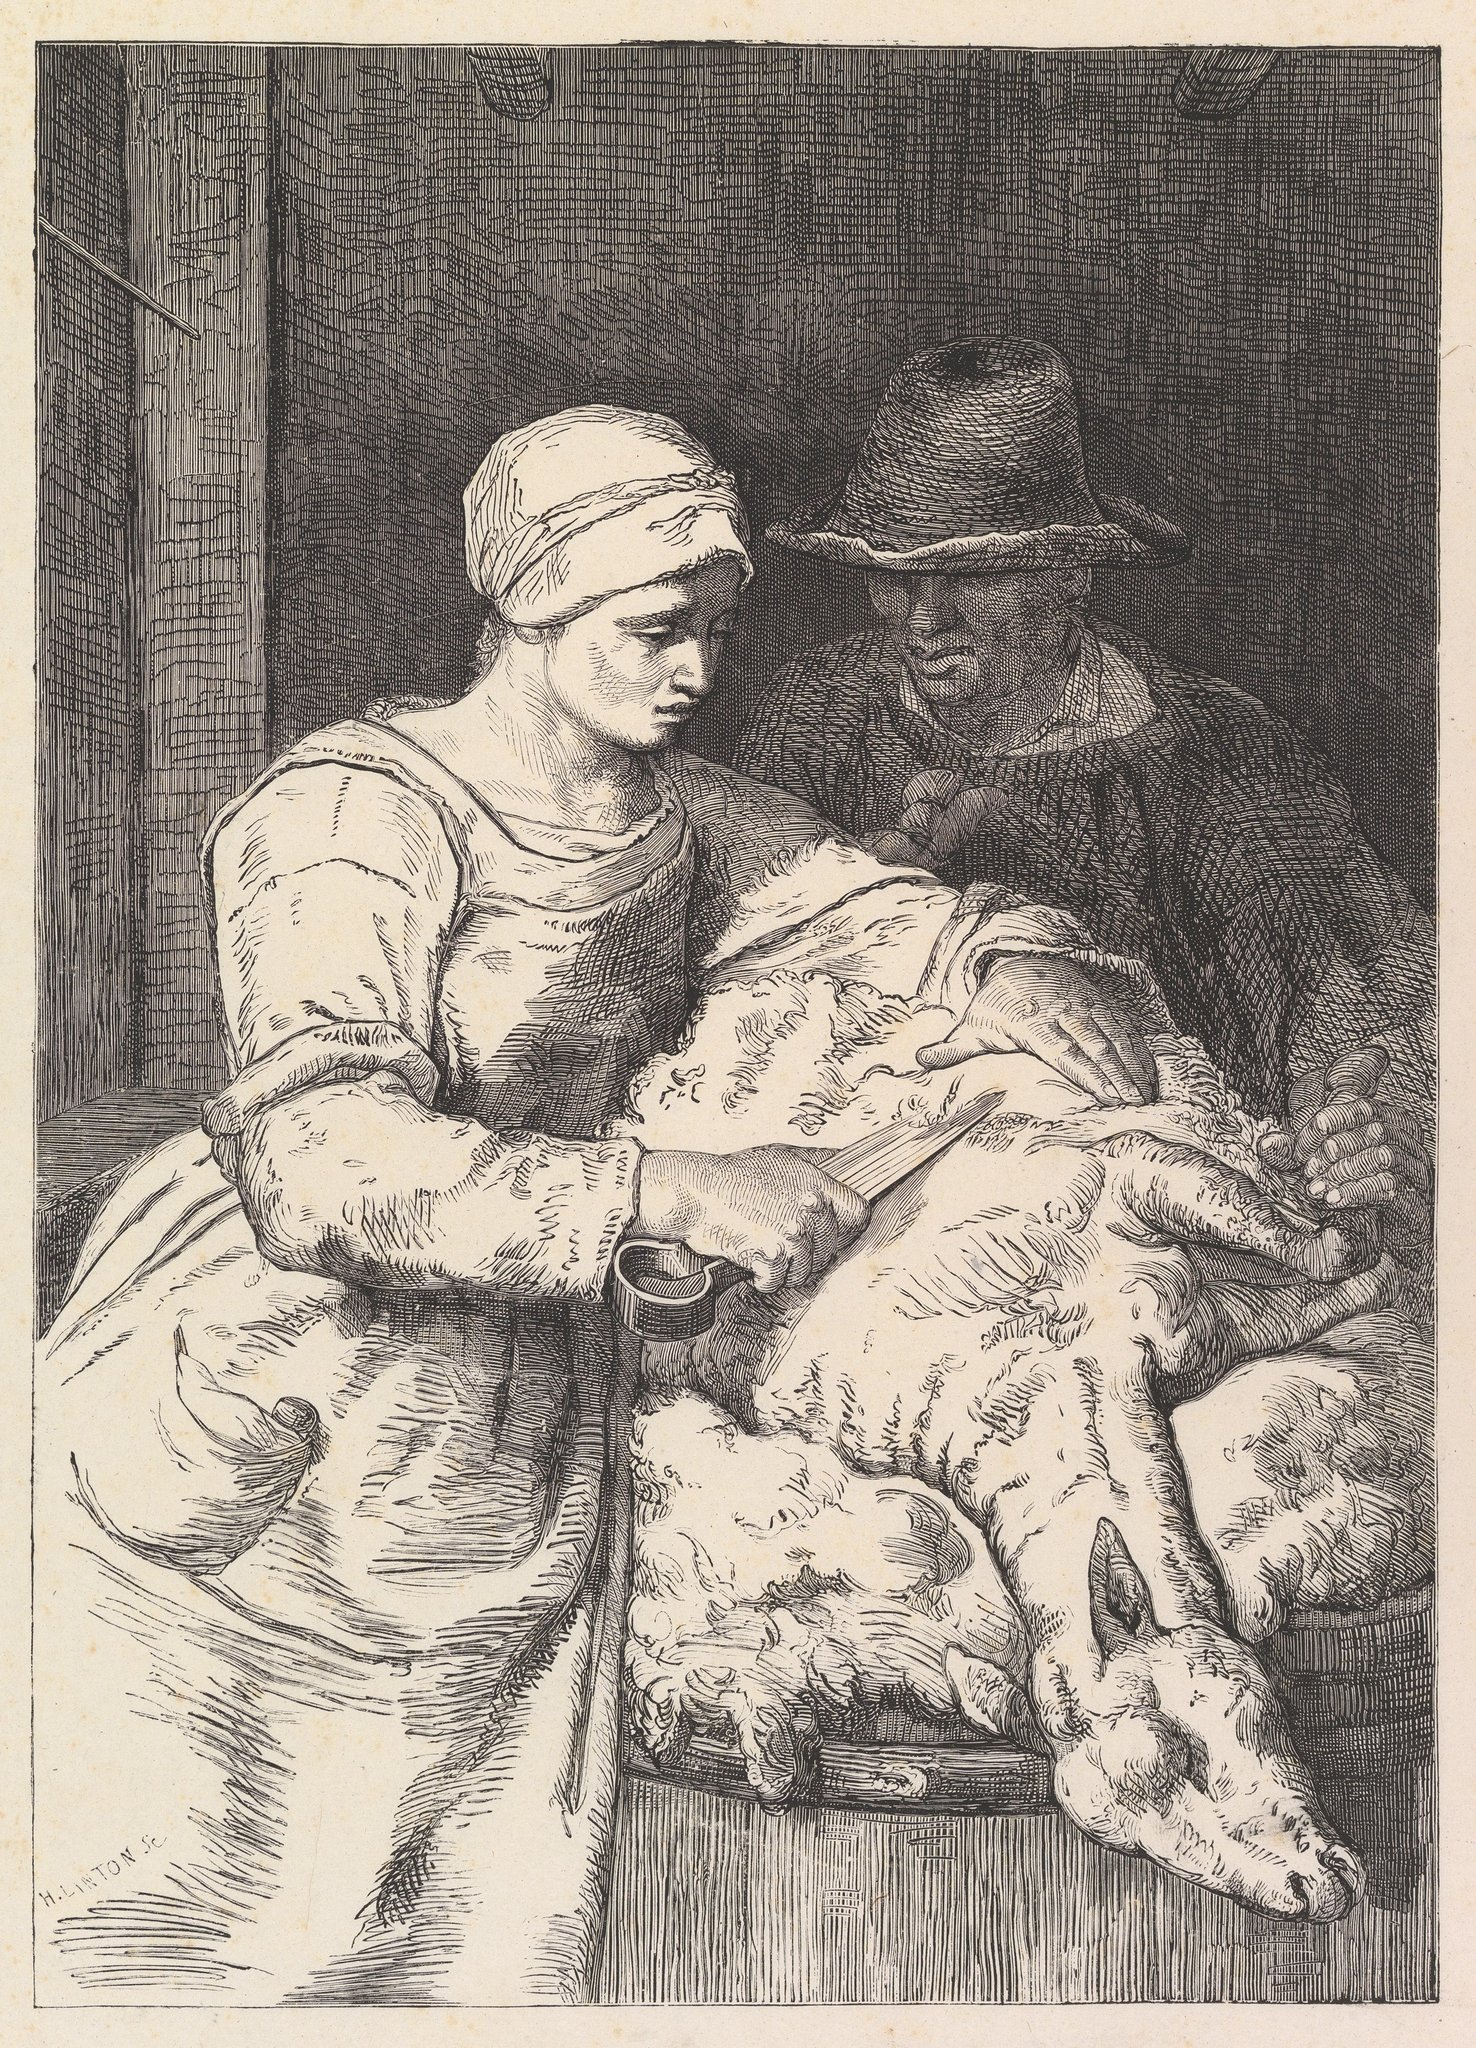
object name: print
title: The Sheepshearer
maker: henry linton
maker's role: artist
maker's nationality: british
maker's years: 1815-1899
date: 1801-1900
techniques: woodcut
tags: men,women,sheep